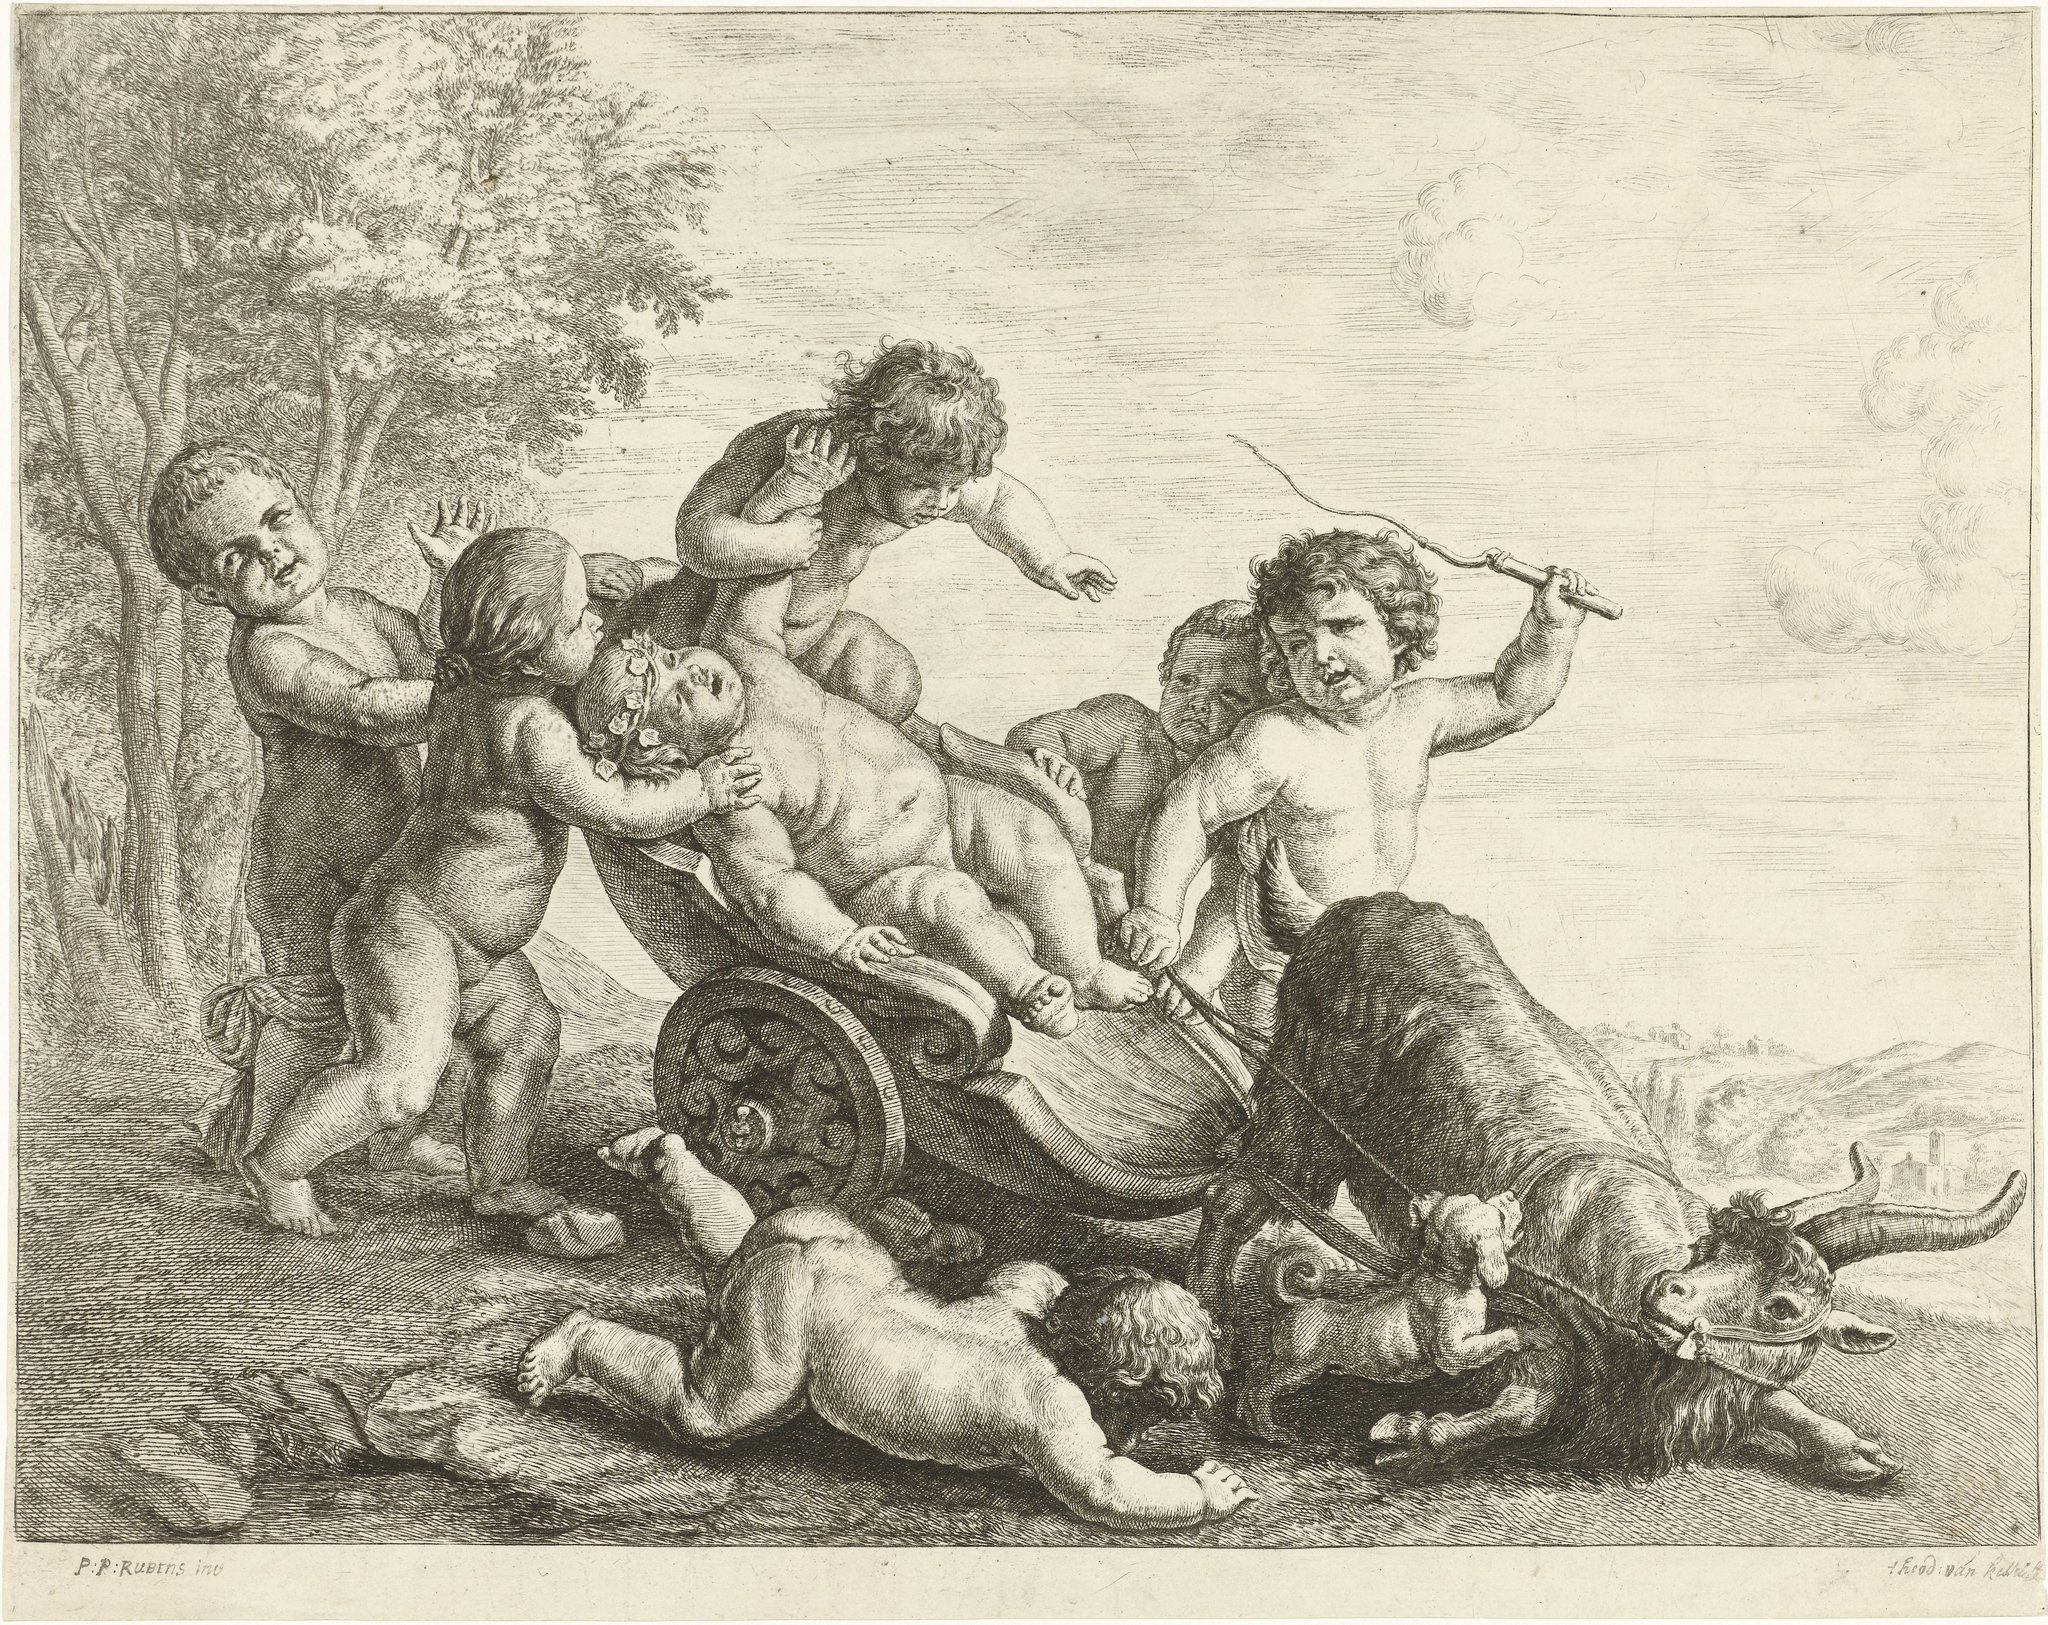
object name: print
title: Putti met bokkenwagen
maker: johannes gronsveld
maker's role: draughtsman, painter, print maker, publisher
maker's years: 1658-1728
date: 1679-1728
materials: paper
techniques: engraving, etching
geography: amsterdam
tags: cupids: 'amores', 'amoretti', 'putti'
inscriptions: collector's mark: Lugt 240, inscription: ‘theod. van kessel fec’, inscription: ‘P.P. Rubens inv’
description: Landschap met zeven putti in en rondom een bokkenwagen met knielende bok omkijkend naar de wagen. Een putto heeft een zweep boven zijn hoofd geheven en een putto ligt op zijn buik.